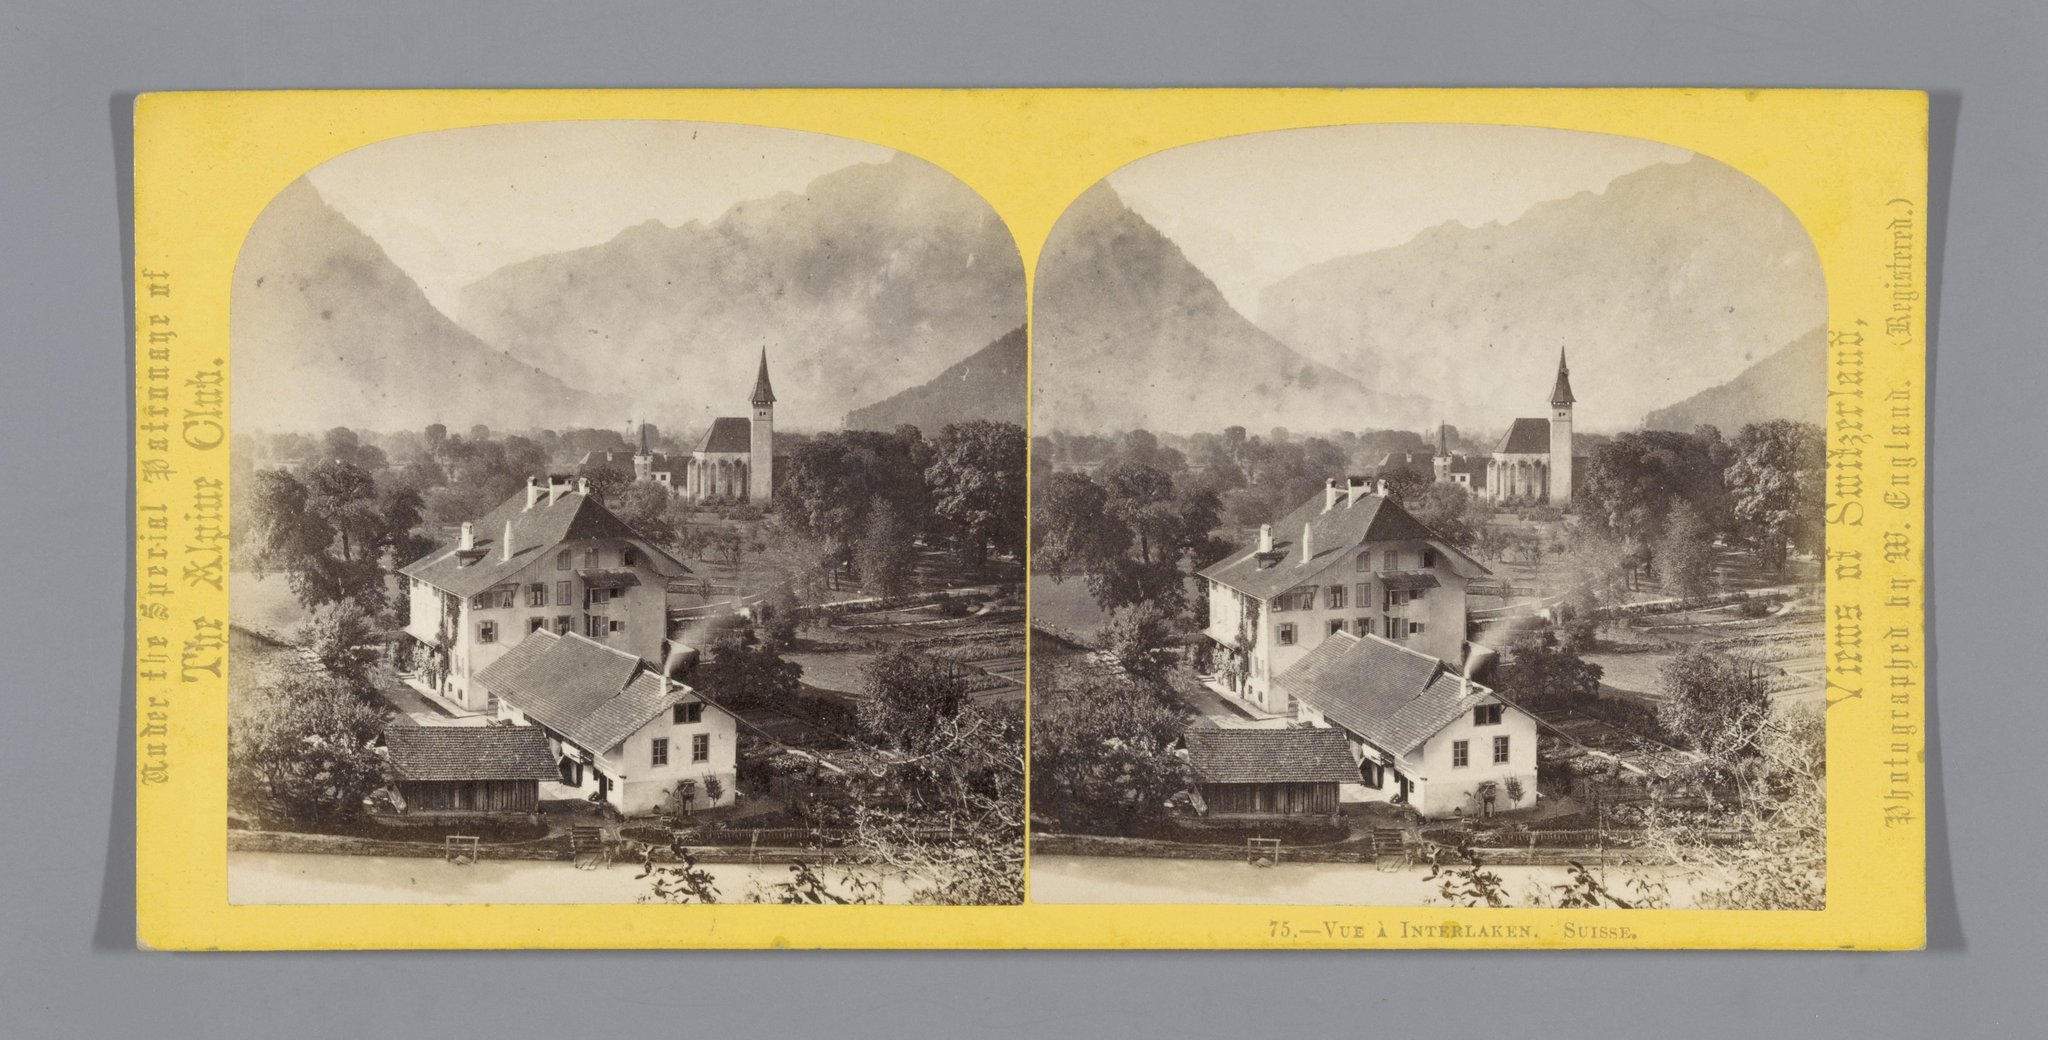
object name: stereograph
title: Gezicht op Interlaken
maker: william england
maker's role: fotograaf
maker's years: 1816-1896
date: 1850-1880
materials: cardboard, photographic support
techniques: albumen print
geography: interlaken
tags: city-view in general; 'veduta', façade (of house or building)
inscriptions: inscription: ‘Views of Switzerland, photographed by W. England. (Registered) Under the Special Patronage of the Alpine Club.’, number: ‘75.’